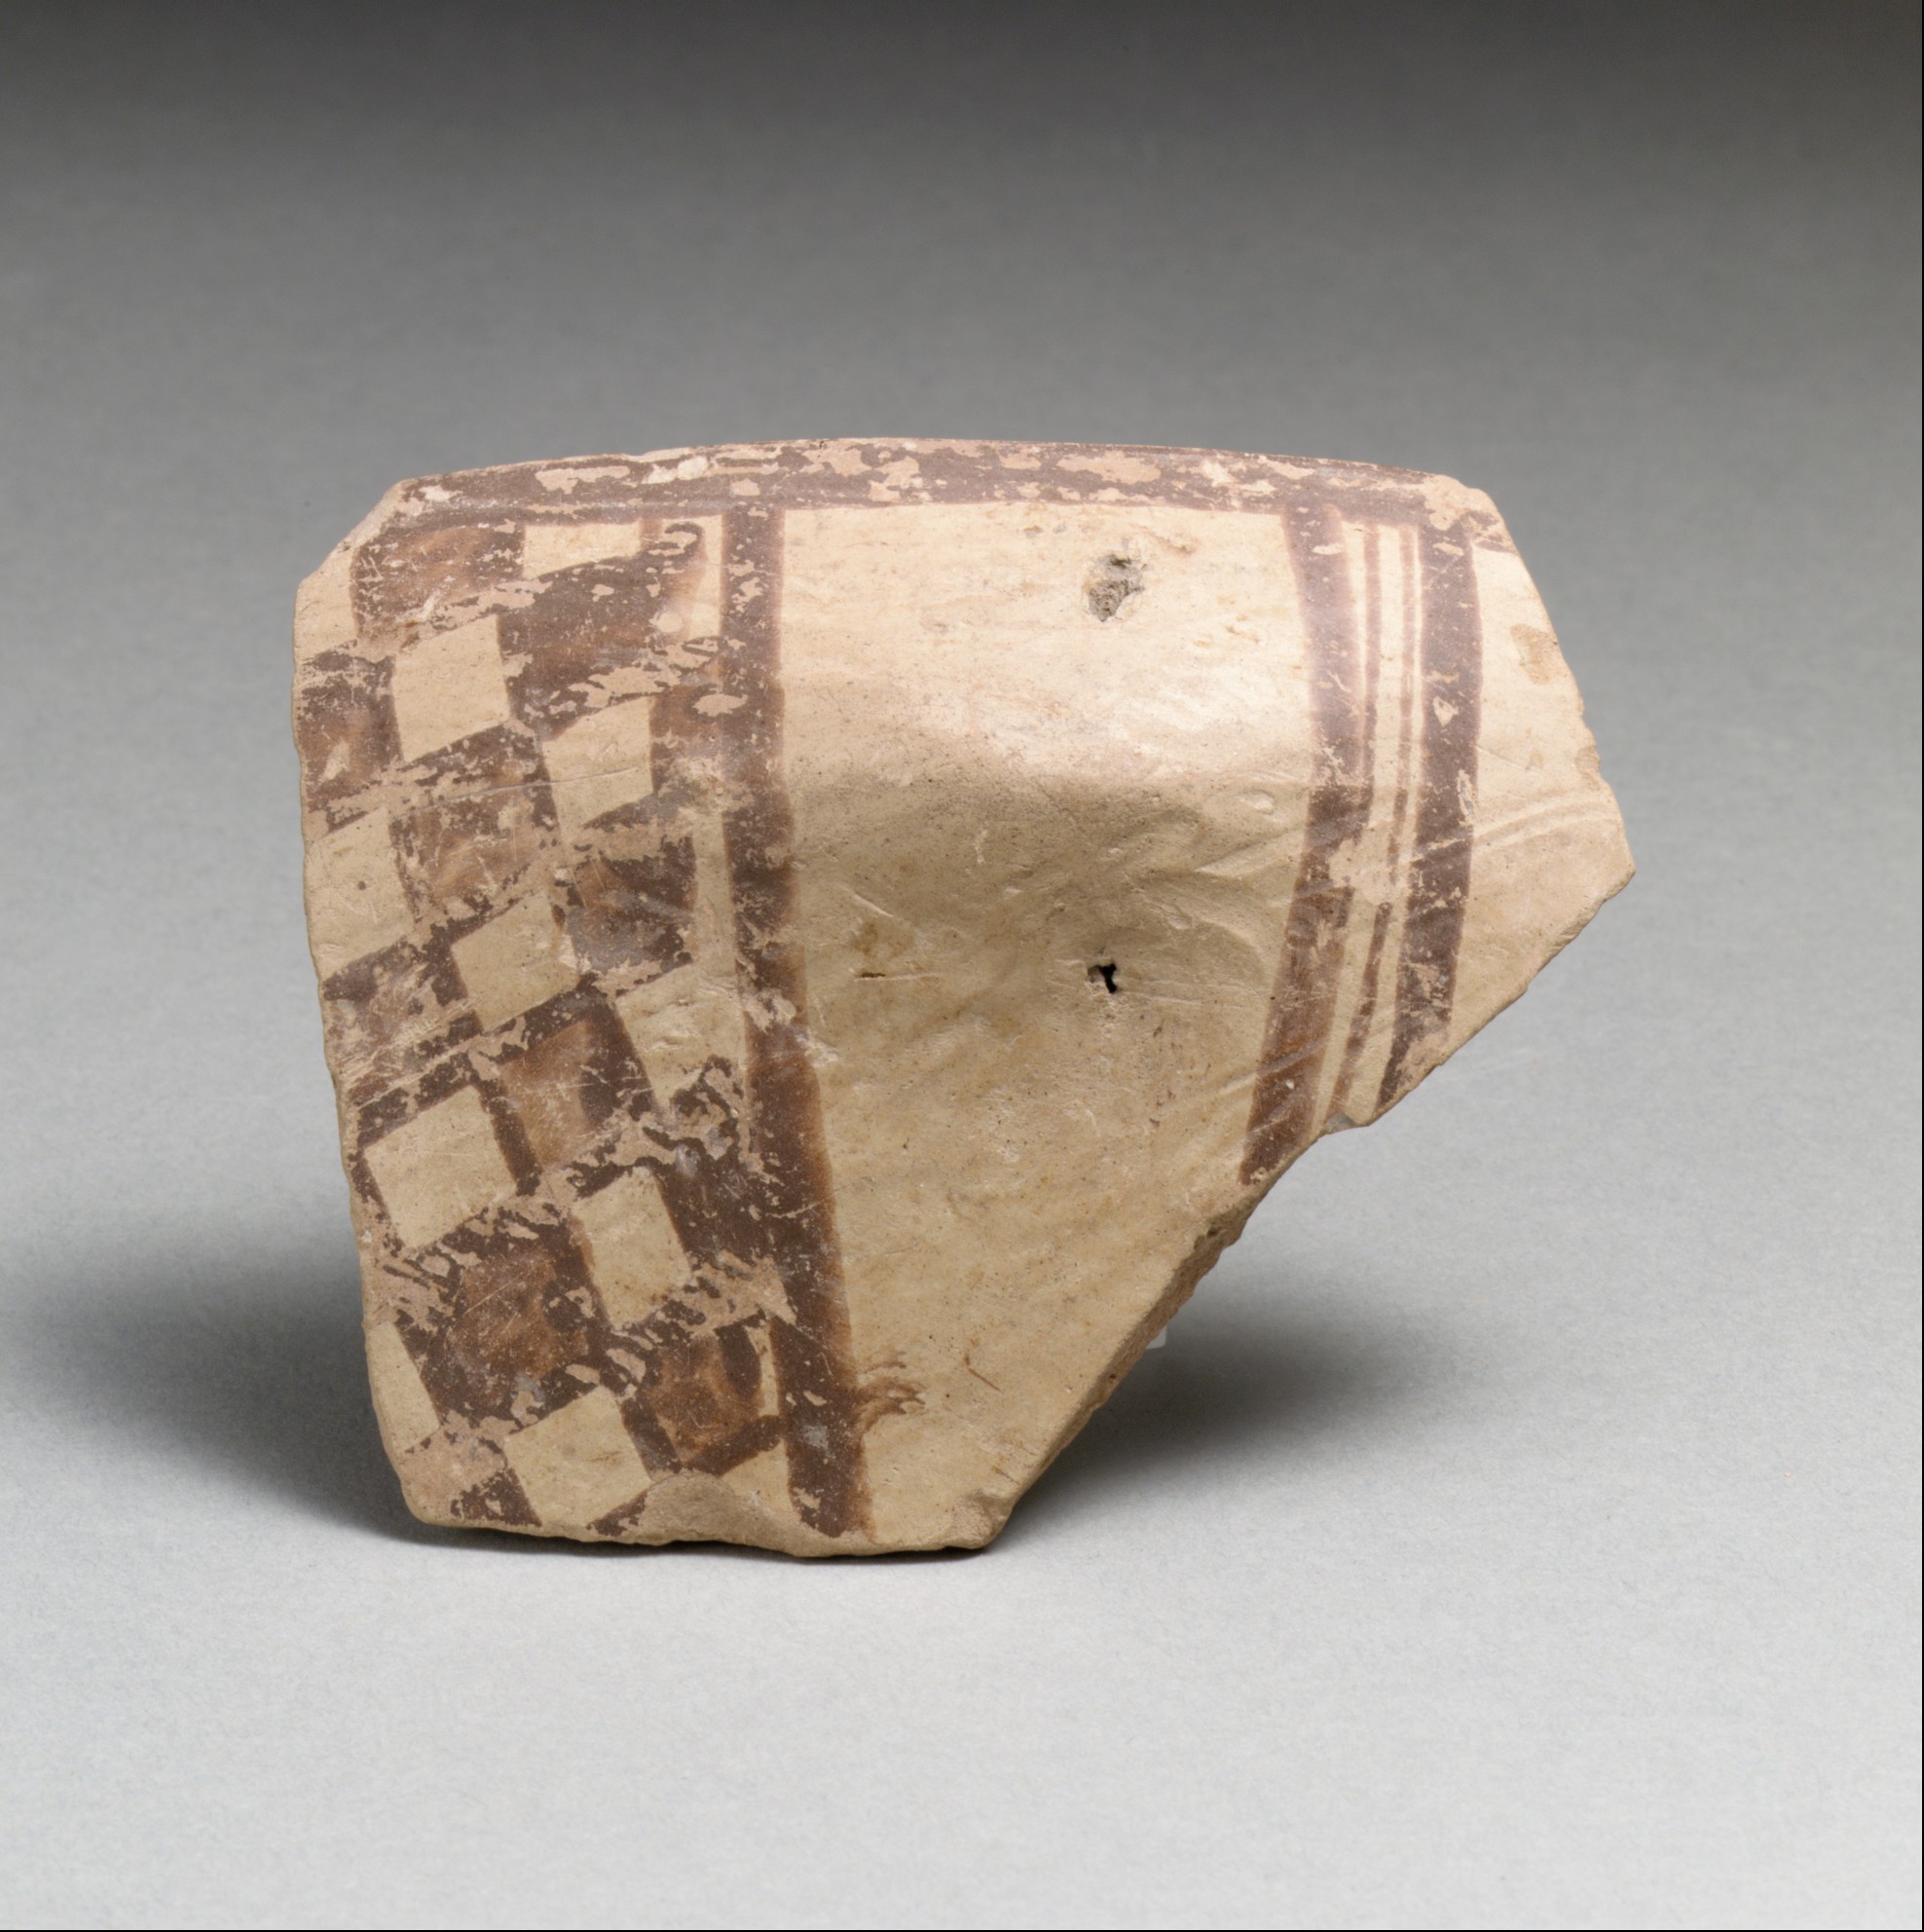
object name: vase fragment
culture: neolithic, thessaly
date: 4000-3000 BCE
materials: terracotta